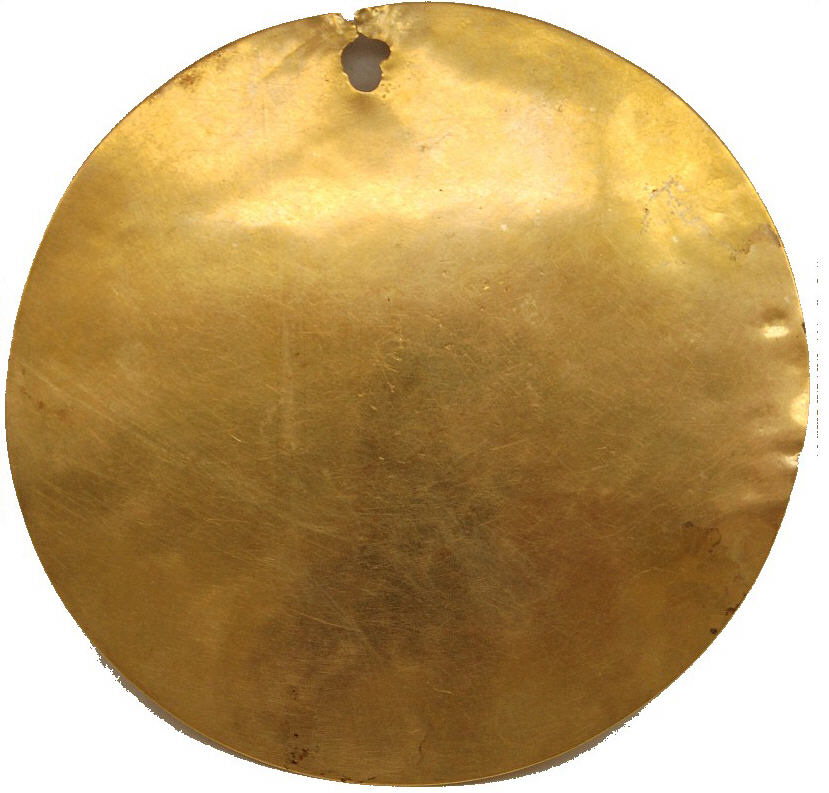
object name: disk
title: Ornamental Disk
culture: capuli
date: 801-1300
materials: gold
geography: ecuador